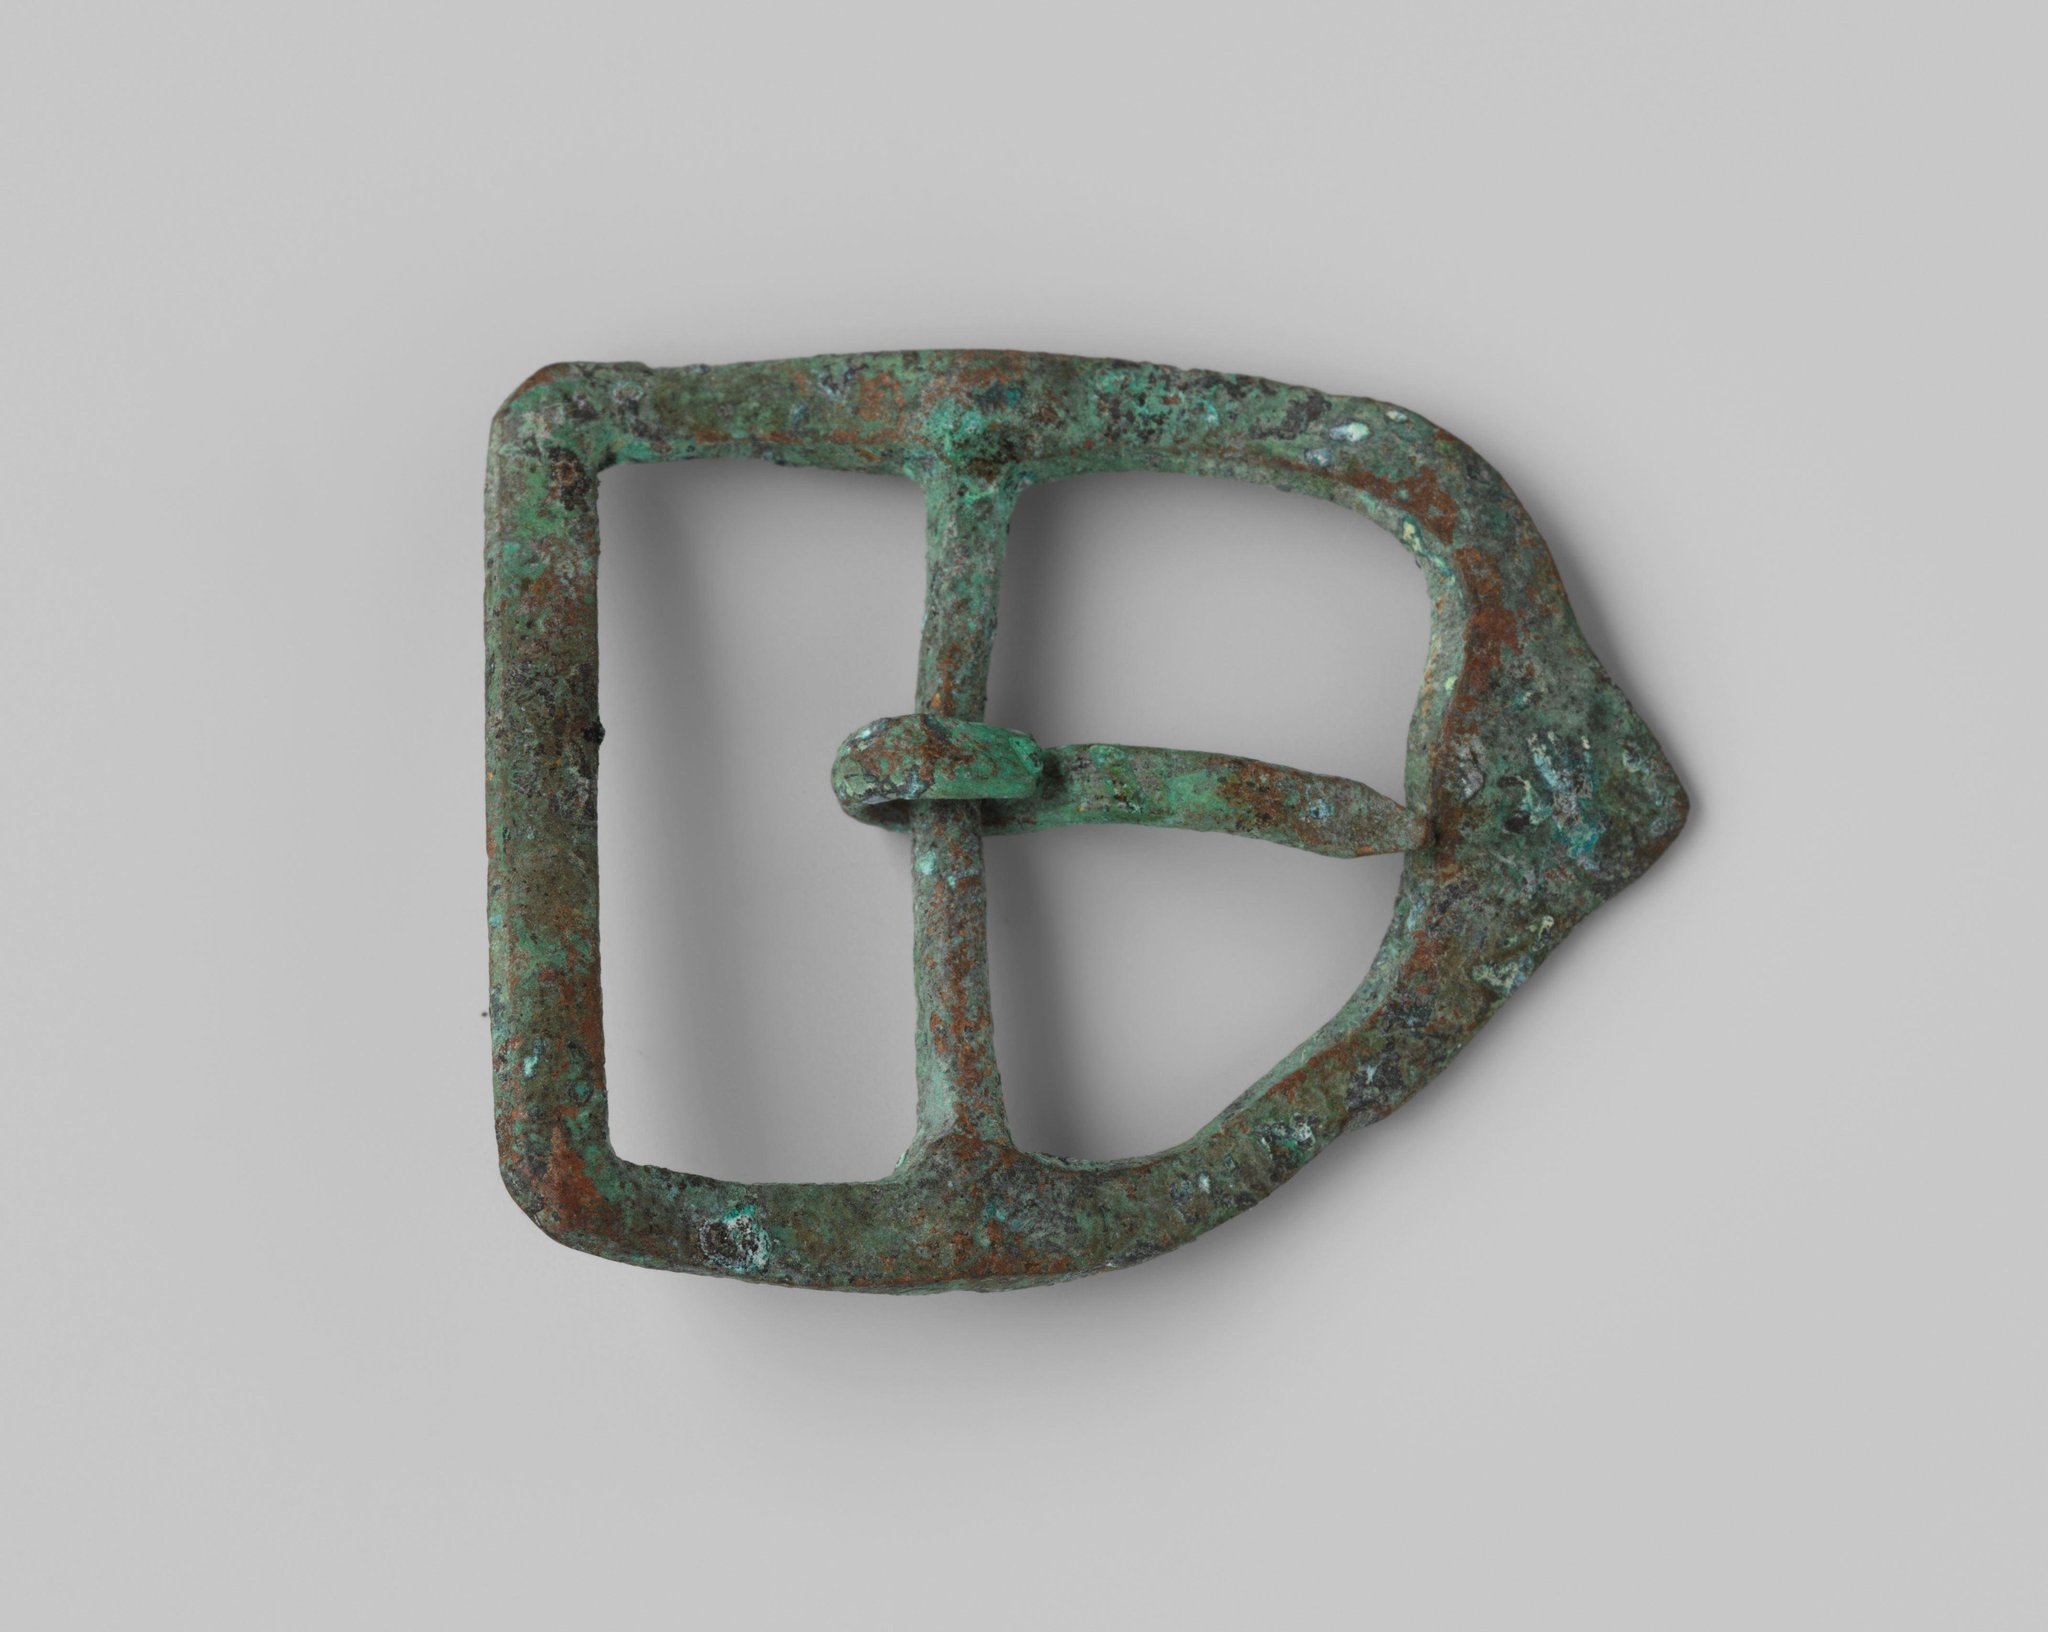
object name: belt buckle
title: Riemgesp uit het wrak van de Oost-Indiëvaarder Hollandia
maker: Anonymous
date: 1700-1743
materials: copper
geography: netherlands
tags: verenigde oostindische compagnie, hollandia (schip), annet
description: D-shaped with pointed side, ring with spindle and tongue, belt buckle.